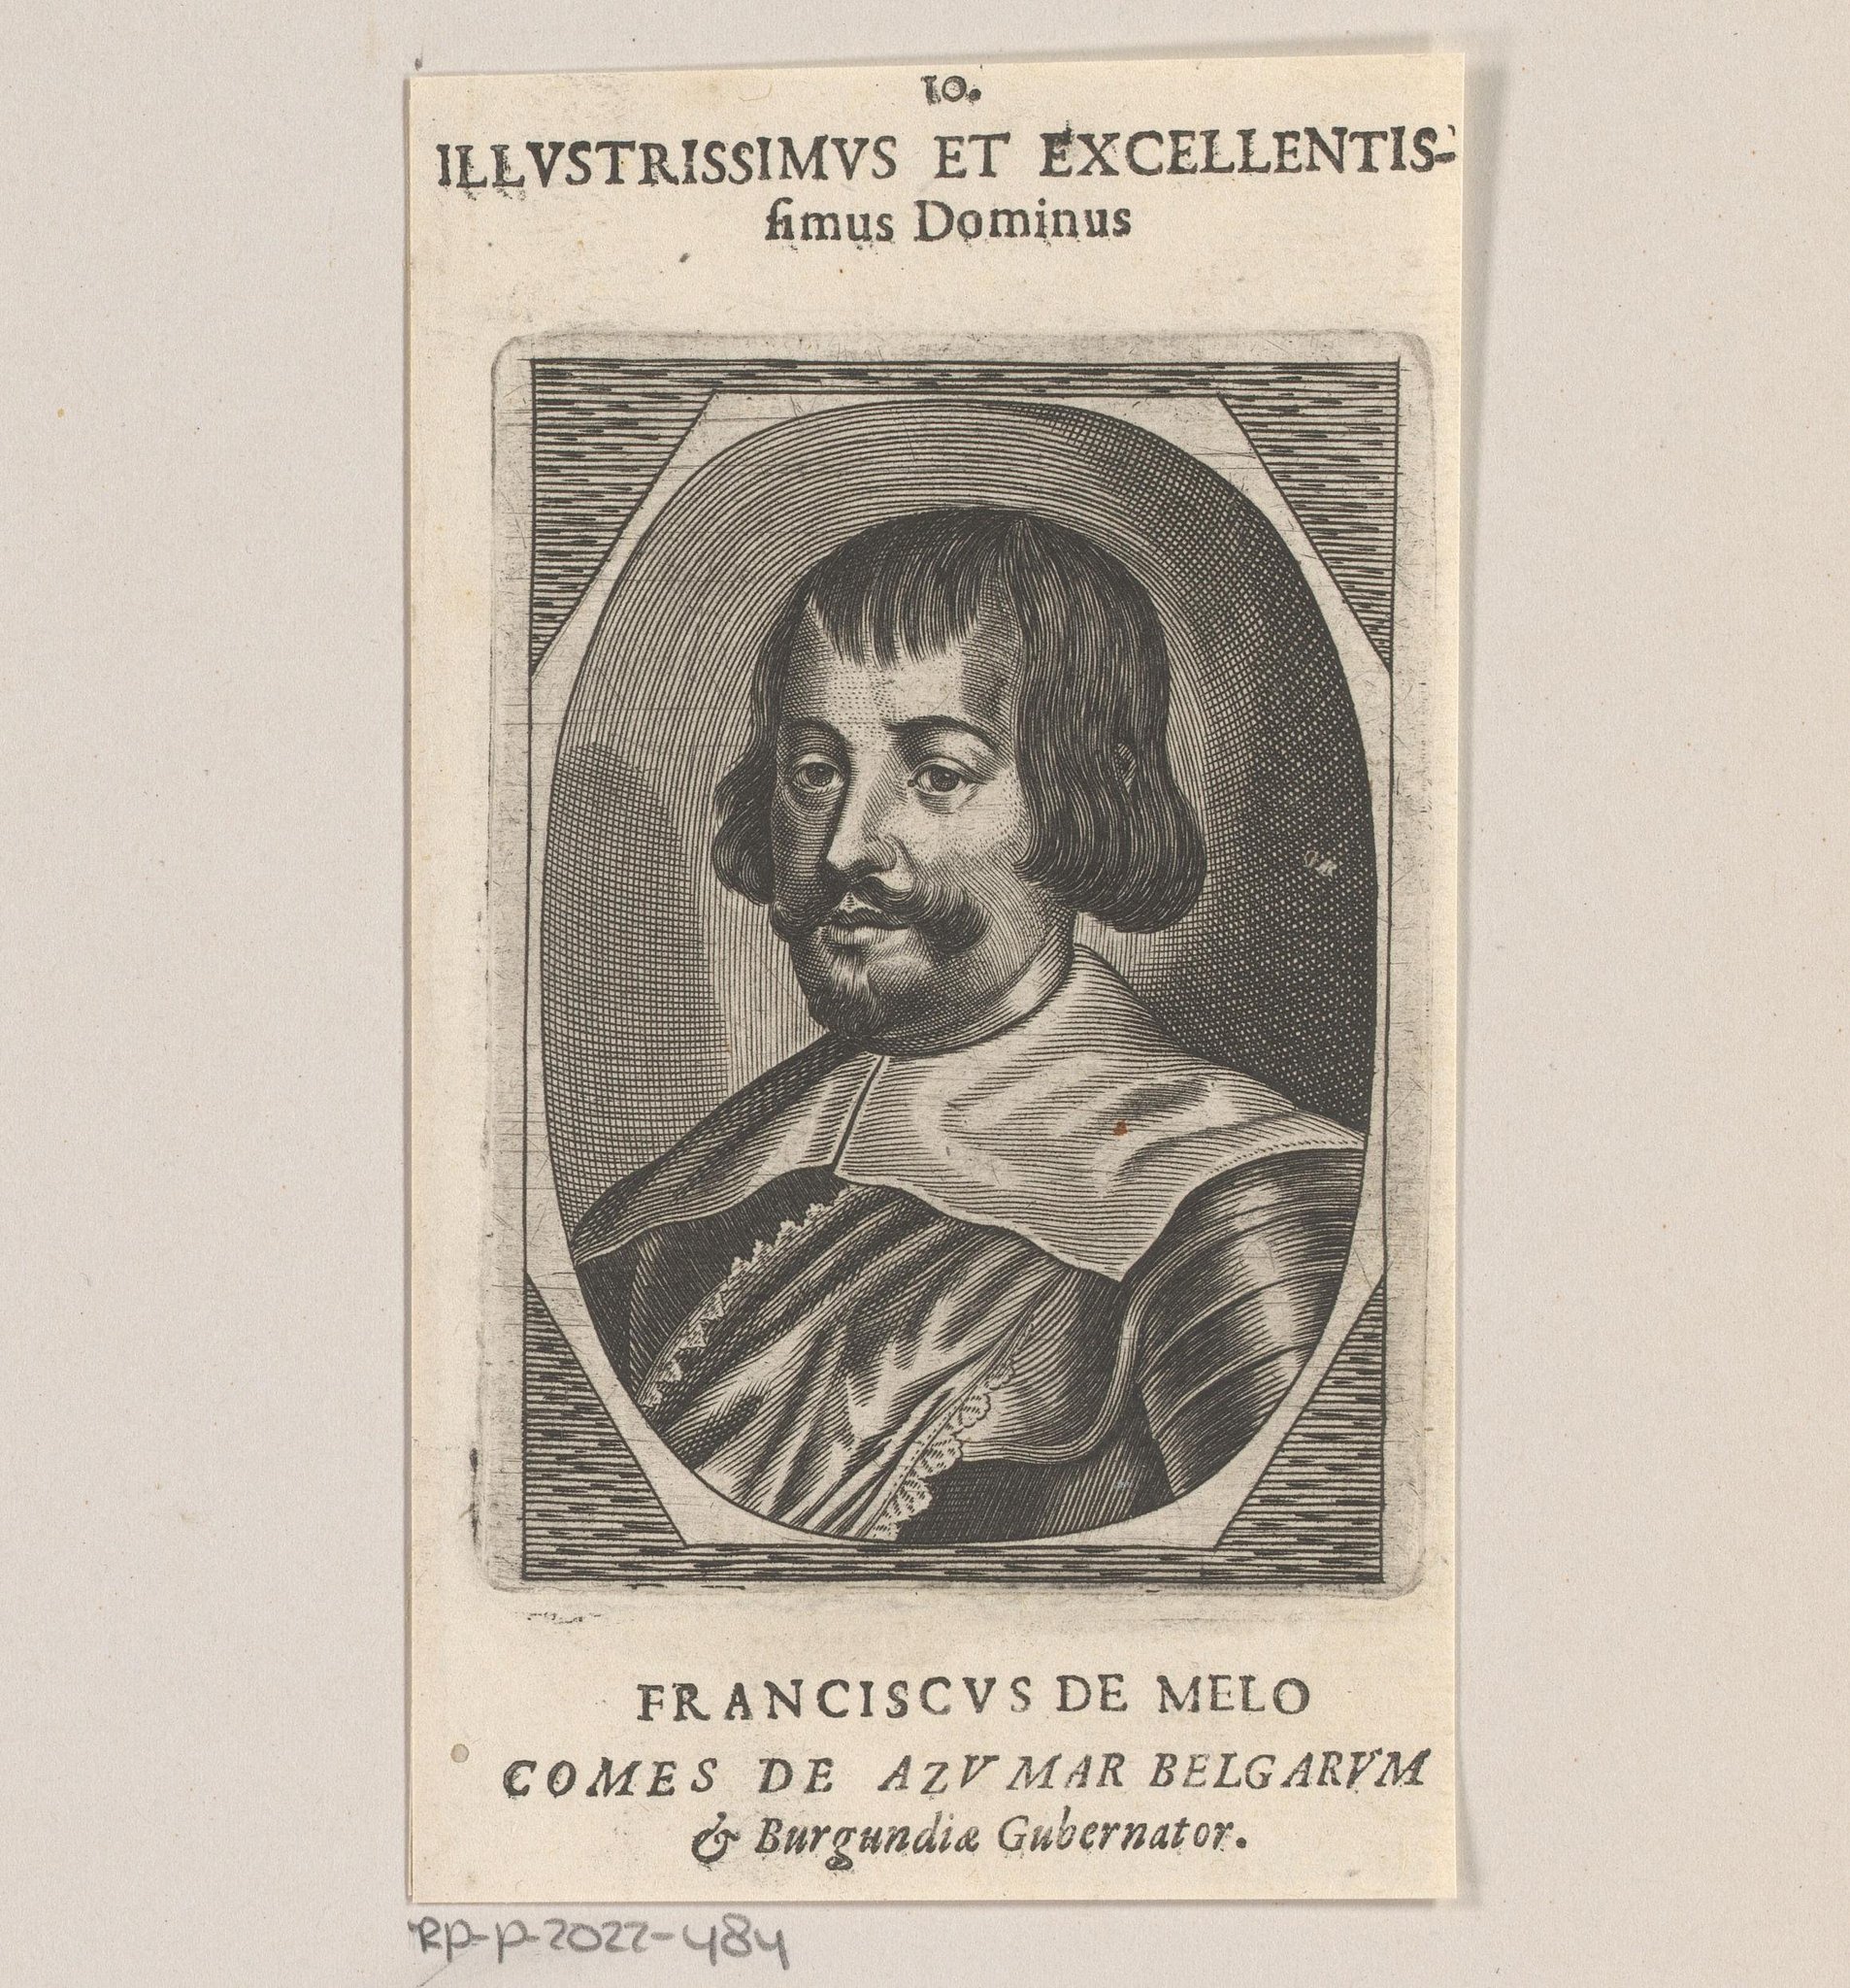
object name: print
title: Portret van Francisco de Melo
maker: Anonymous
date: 1650-1750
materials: paper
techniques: engraving, letterpress printing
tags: historical persons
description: Bovenaan: 10. Met eenregelig bovenschrift in het Latijn.